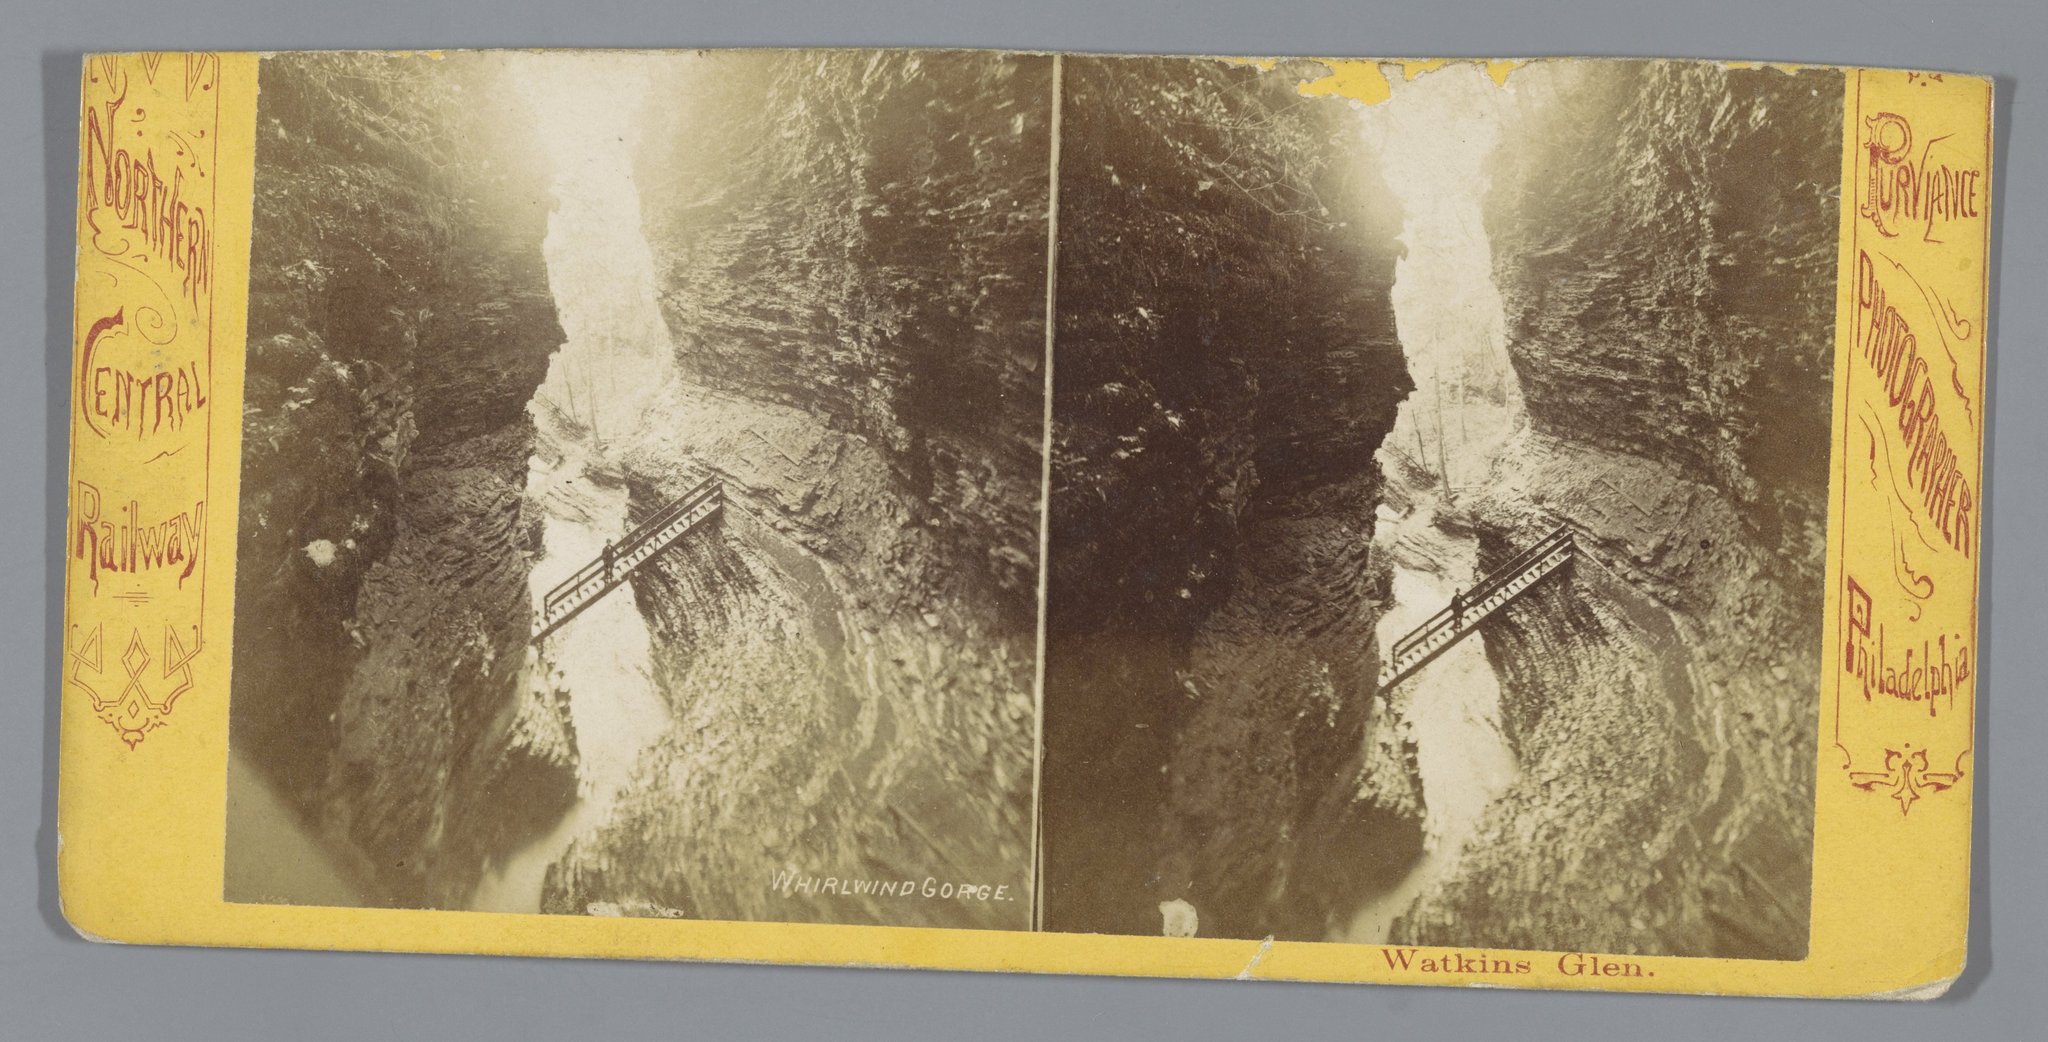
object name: stereograph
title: Whirlwind Gorge in Watkins Glen State Park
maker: william t. purviance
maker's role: publisher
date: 1860-1880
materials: cardboard, paper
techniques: albumen print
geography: watkins glen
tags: rock-formations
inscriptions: title: ‘Whirlwind Gorge’